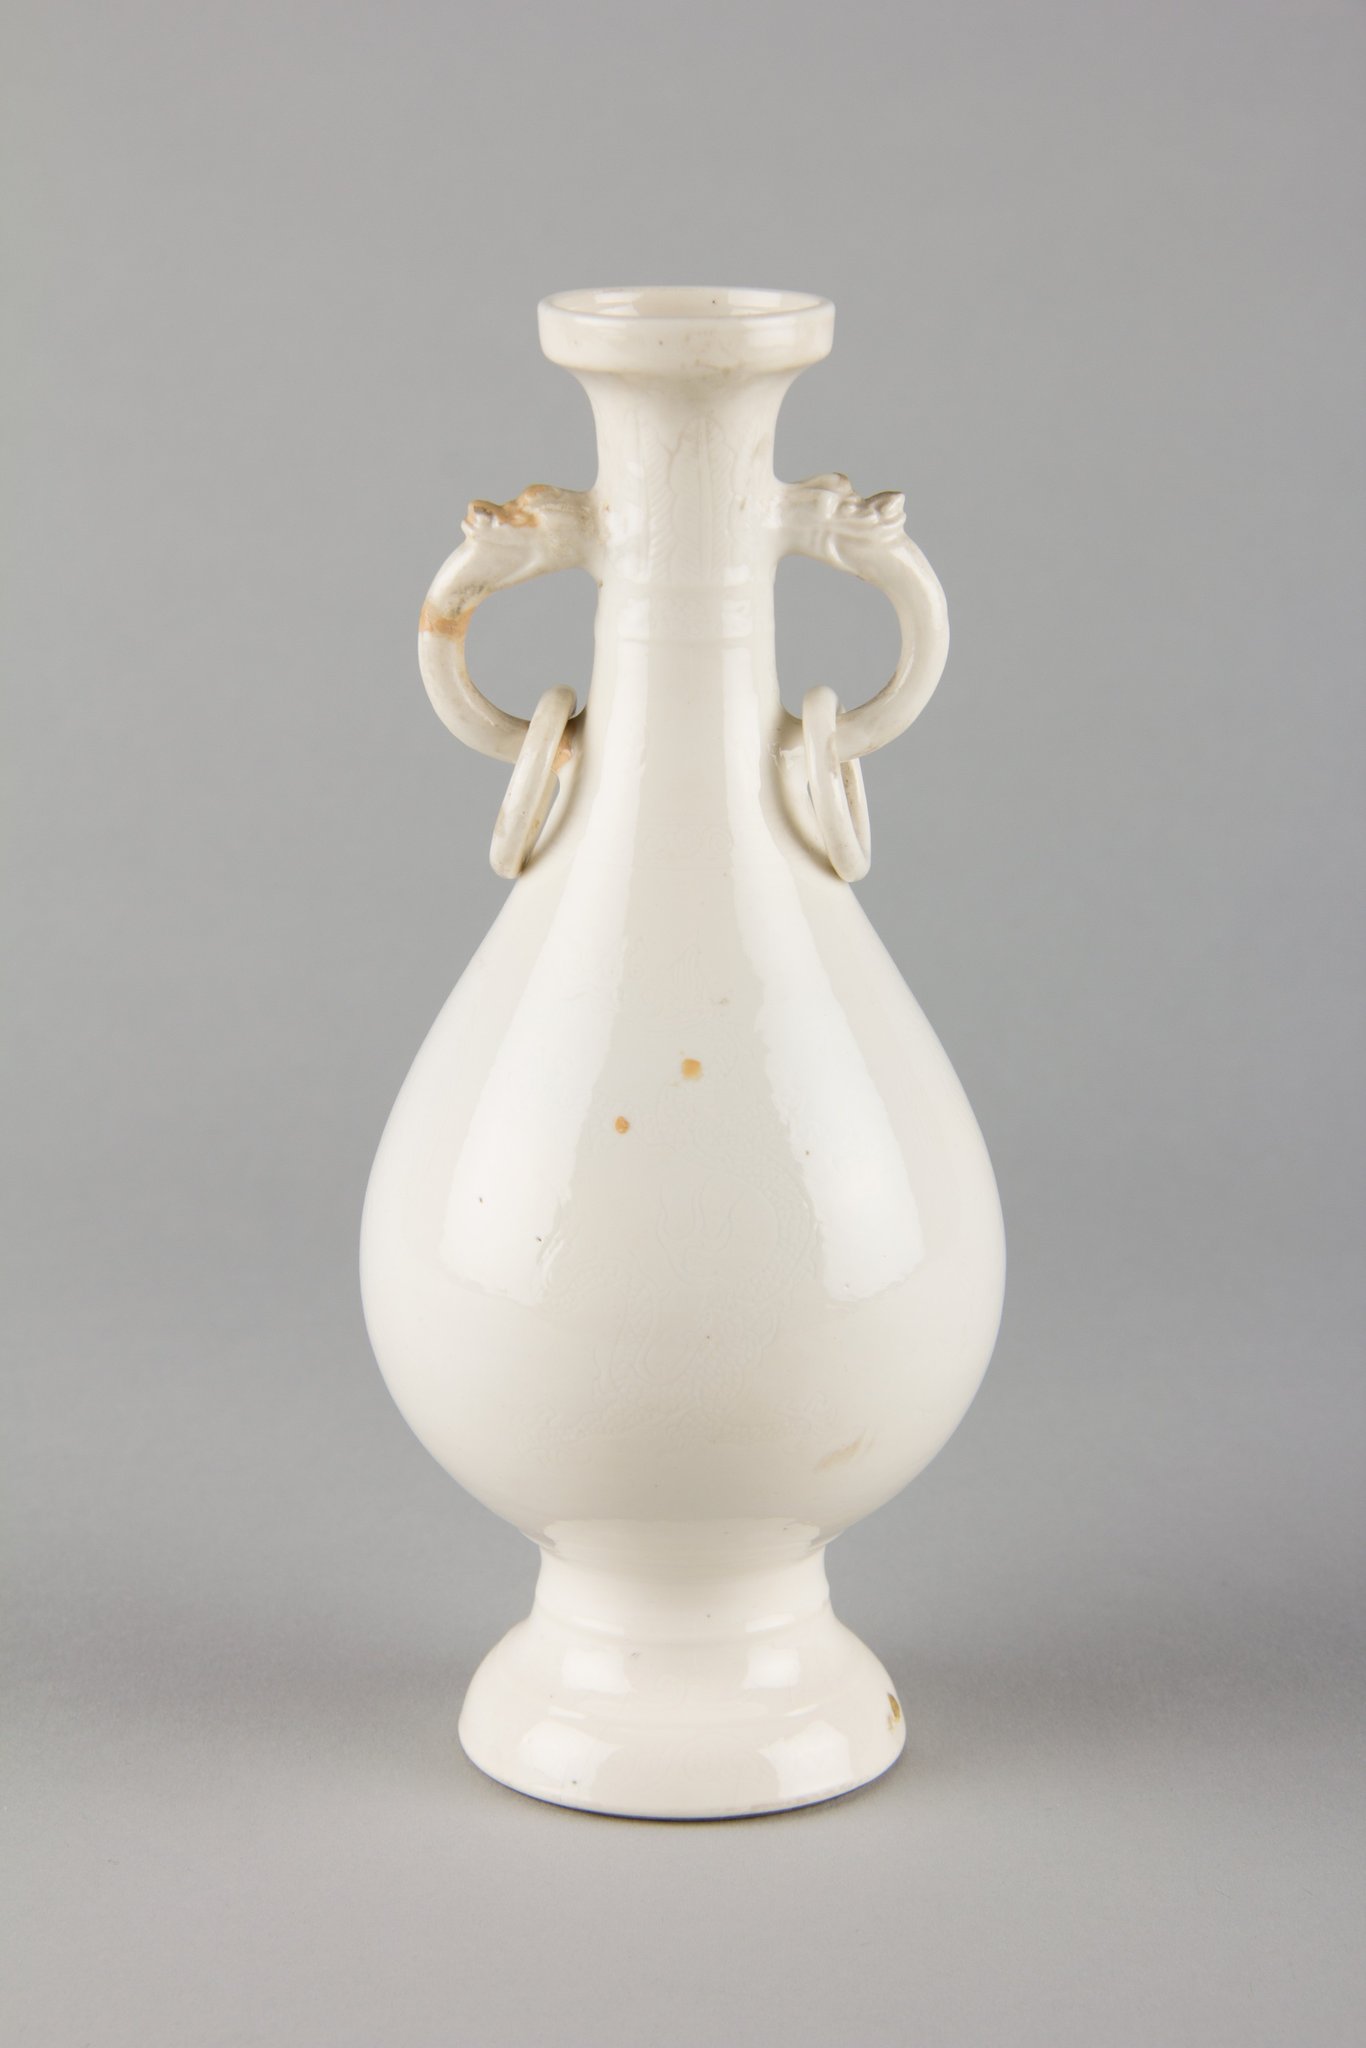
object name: vase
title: Vase with ring handles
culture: chinese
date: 1701-1800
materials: glaze, soft paste porcelain